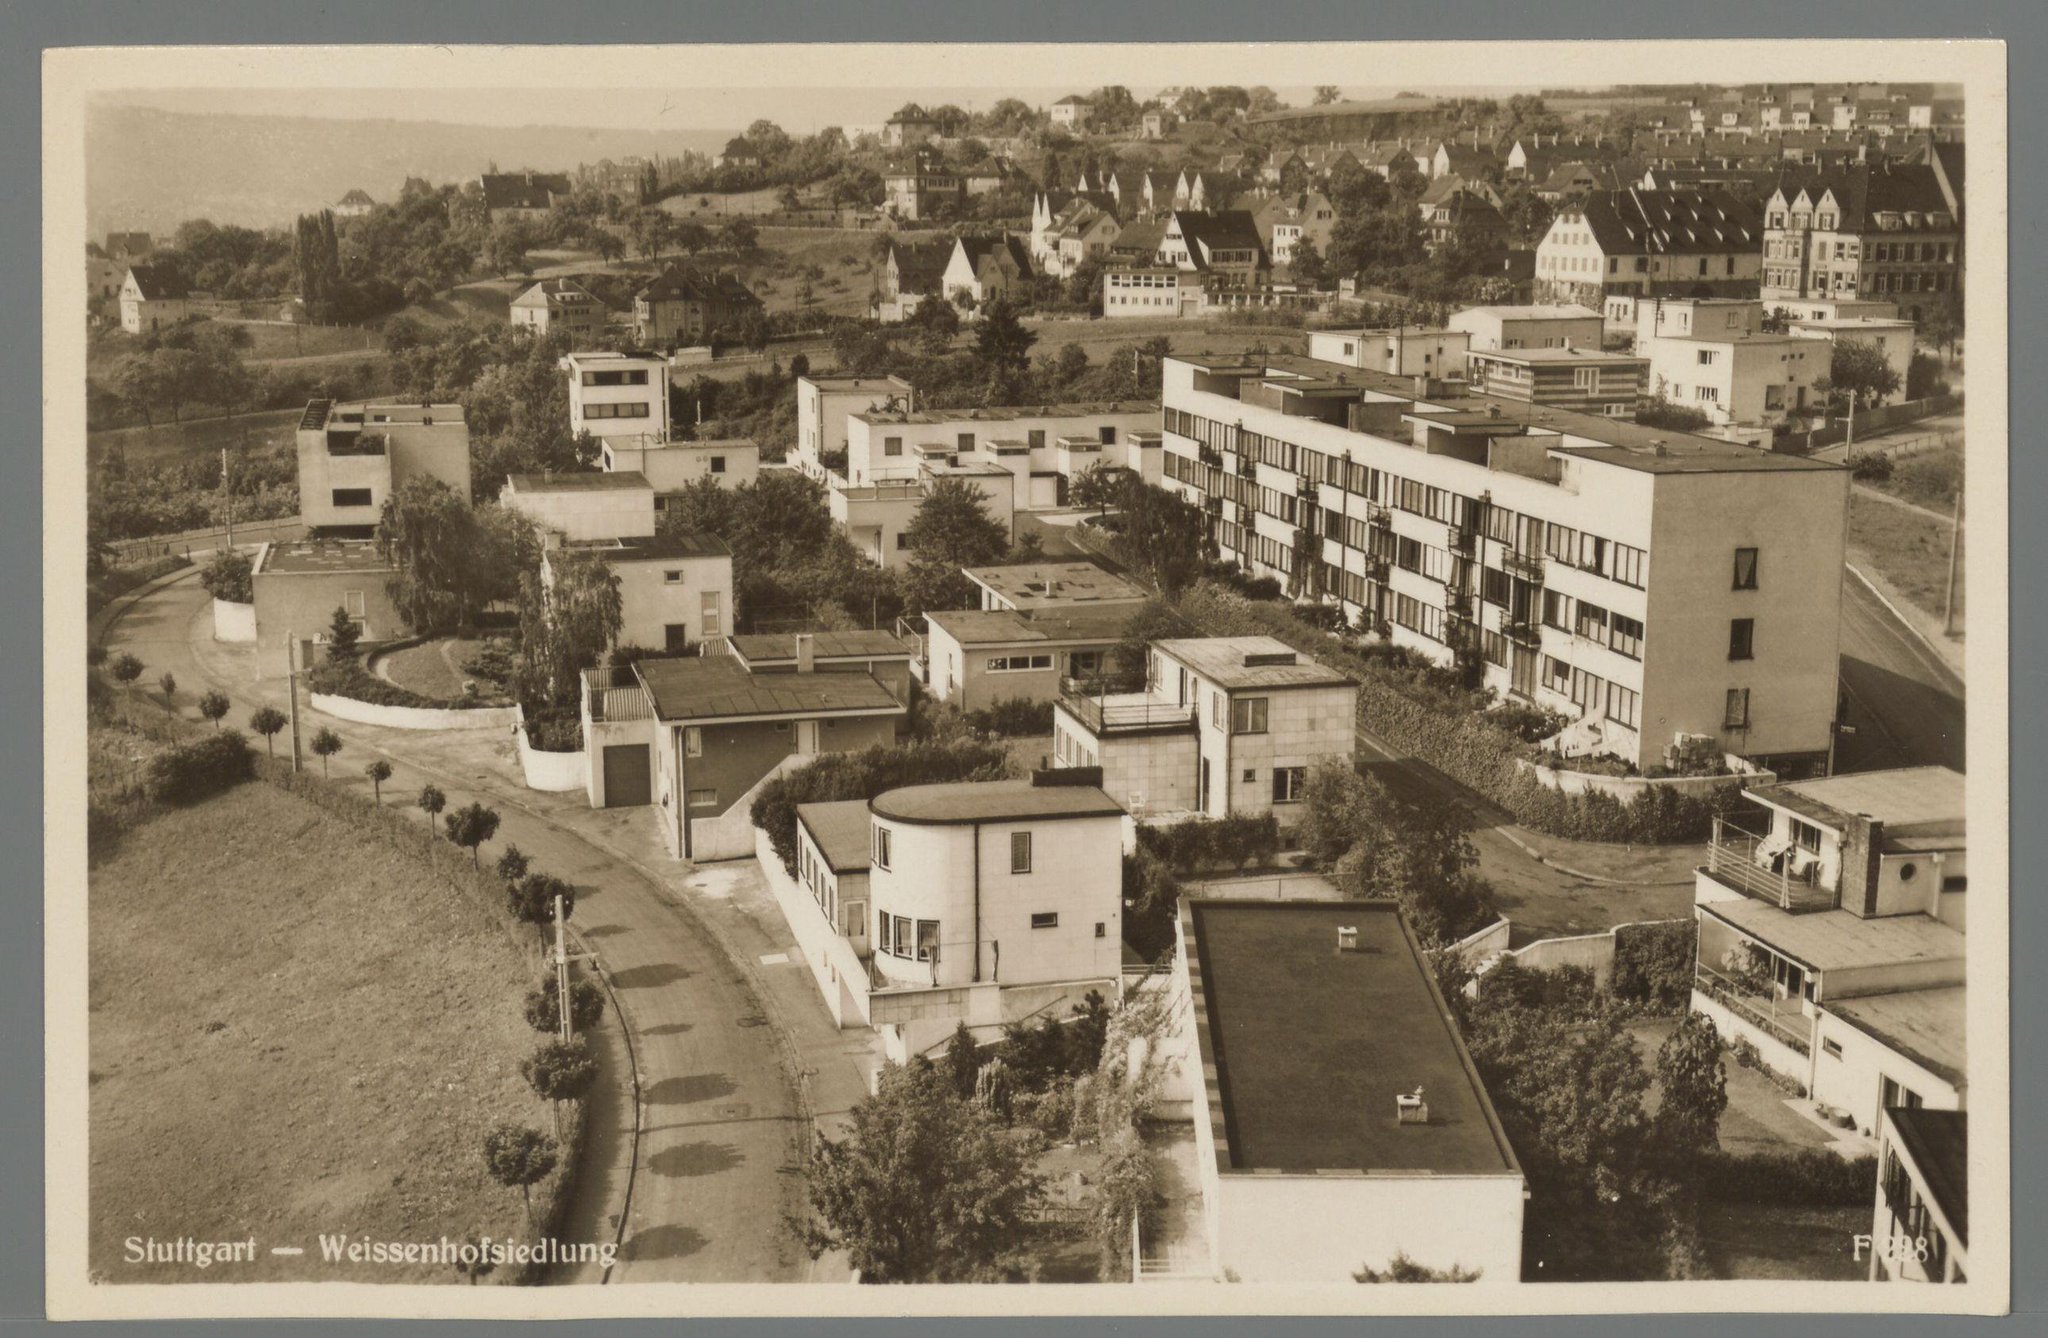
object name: ansichtkaart, prentbriefkaart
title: Stuttgart - Weissenhofsiedlung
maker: w. fink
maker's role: publisher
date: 1927-1930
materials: photographic support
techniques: photography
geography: stuttgart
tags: urban housing, city-view, and landscape with man-made constructions